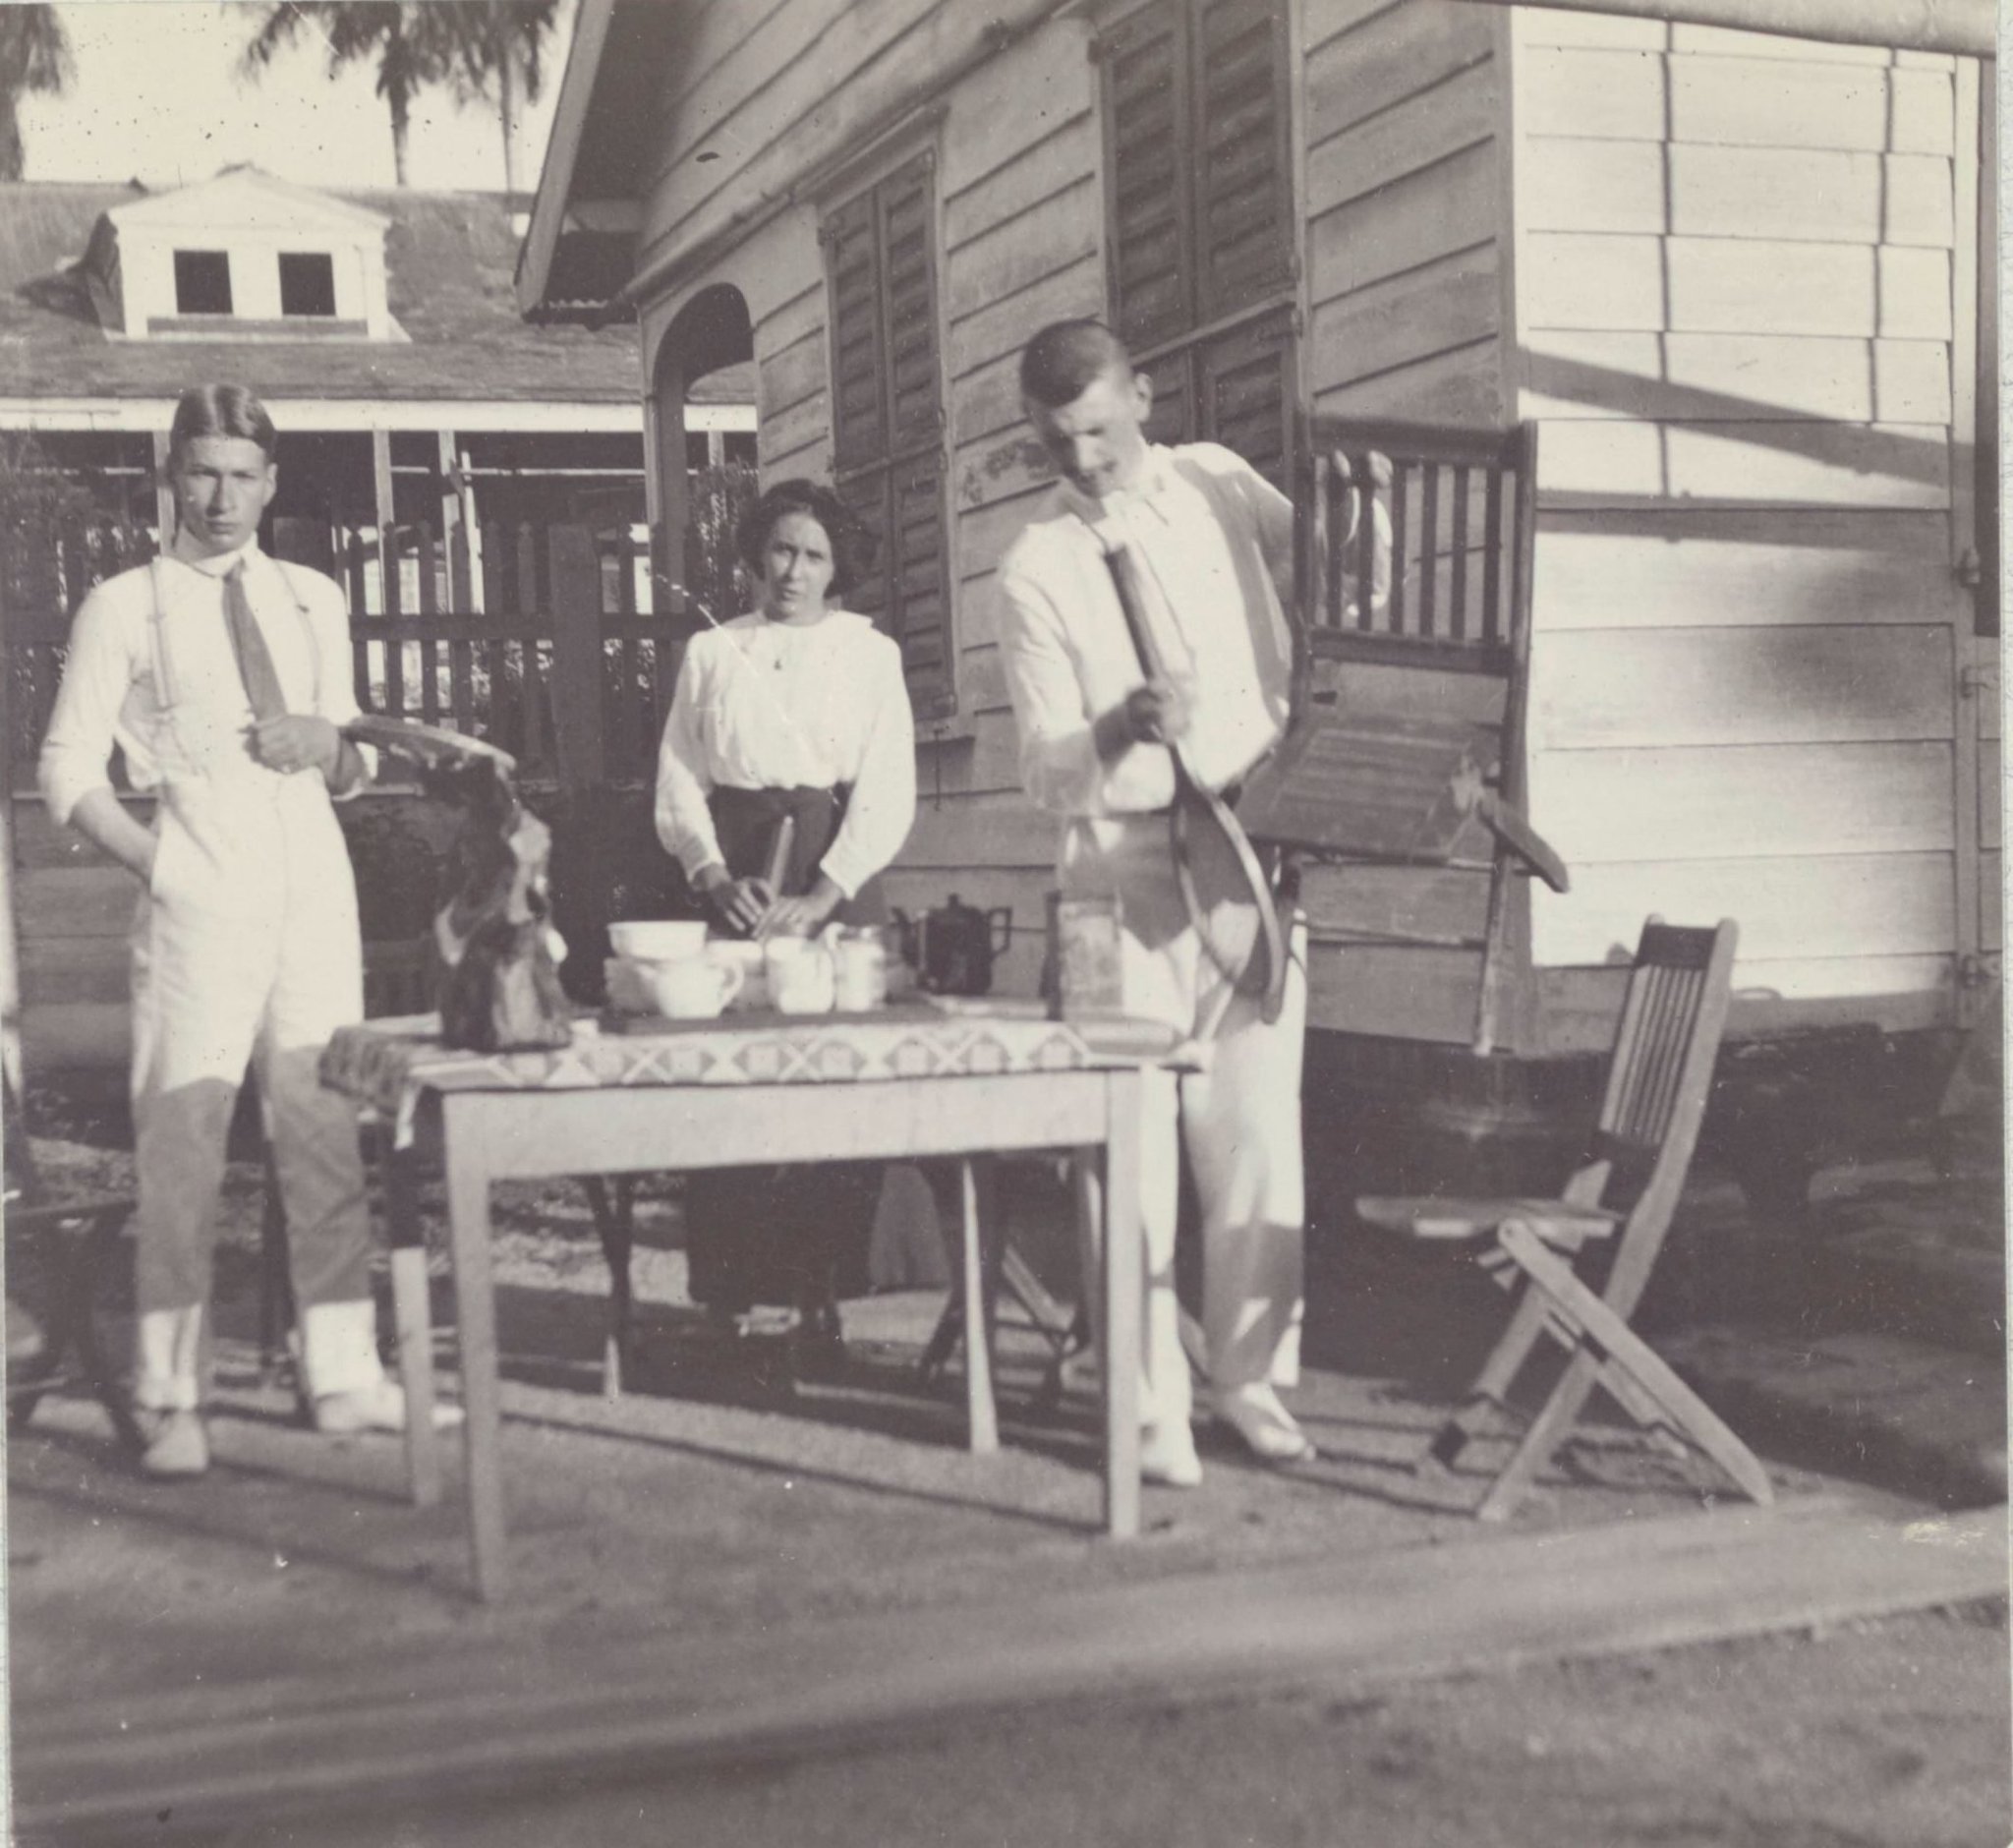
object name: photograph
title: Op de tennisbaan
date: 1909-1911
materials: photographic support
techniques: photography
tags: tennis, lawn-tennis, suriname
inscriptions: inscription: ‘Poppy en van der Dullen. / sept. '11’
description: Maria Gonggrijp tussen twee mannen bij het clubhuis van de tennisbaan te Paramaribo. De linker man (elders) aangeduid als 'Oom Daan Boom', de rechter als 'van der Dullen', september 1911. Onderdeel van het fotoalbum van de familie Boom-Gonggrijp in Suriname en Curaçao.